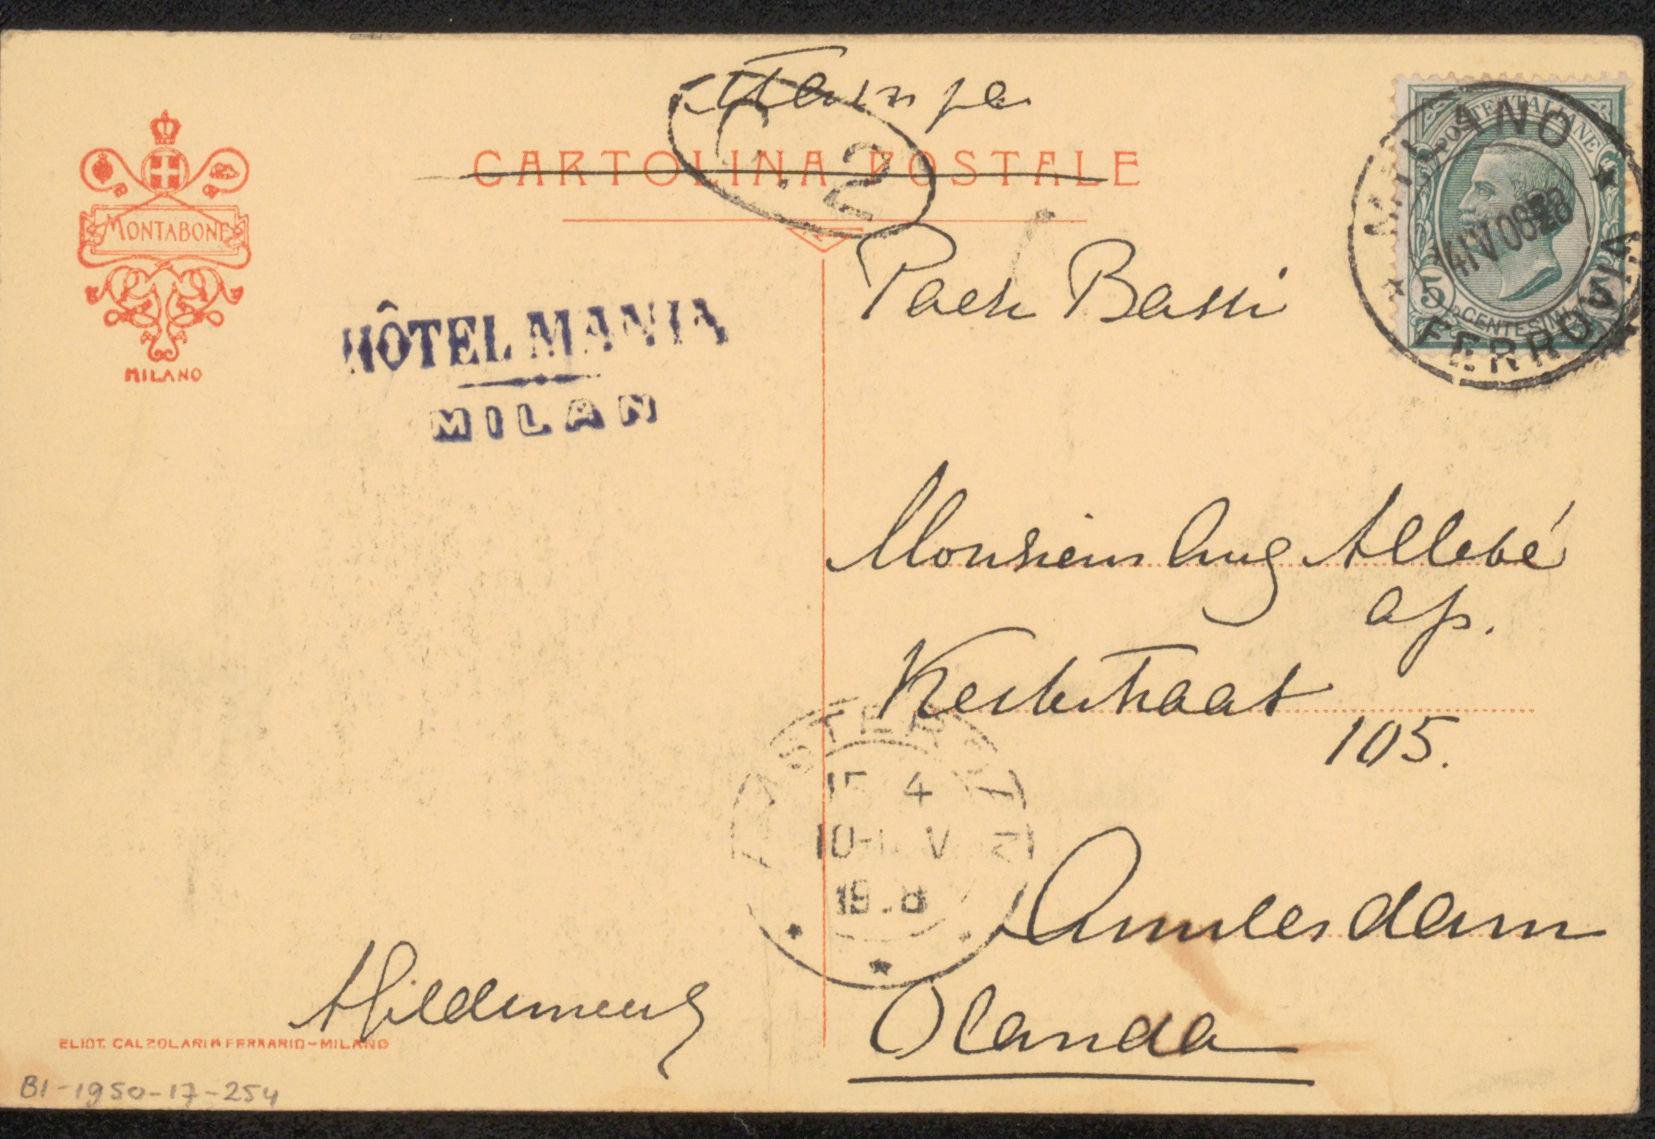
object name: ansichtkaart, prentbriefkaart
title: Prentbriefkaart aan August Allebé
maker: anna gildemeester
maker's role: draughtsman, painter, print maker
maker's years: 1867-1945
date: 1908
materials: cardboard, ink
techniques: photograph, pen, writing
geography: milan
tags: amsterdam, print maker, draughtsman, august allebé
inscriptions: name: ‘HÔTEL MANIA- MILAN’